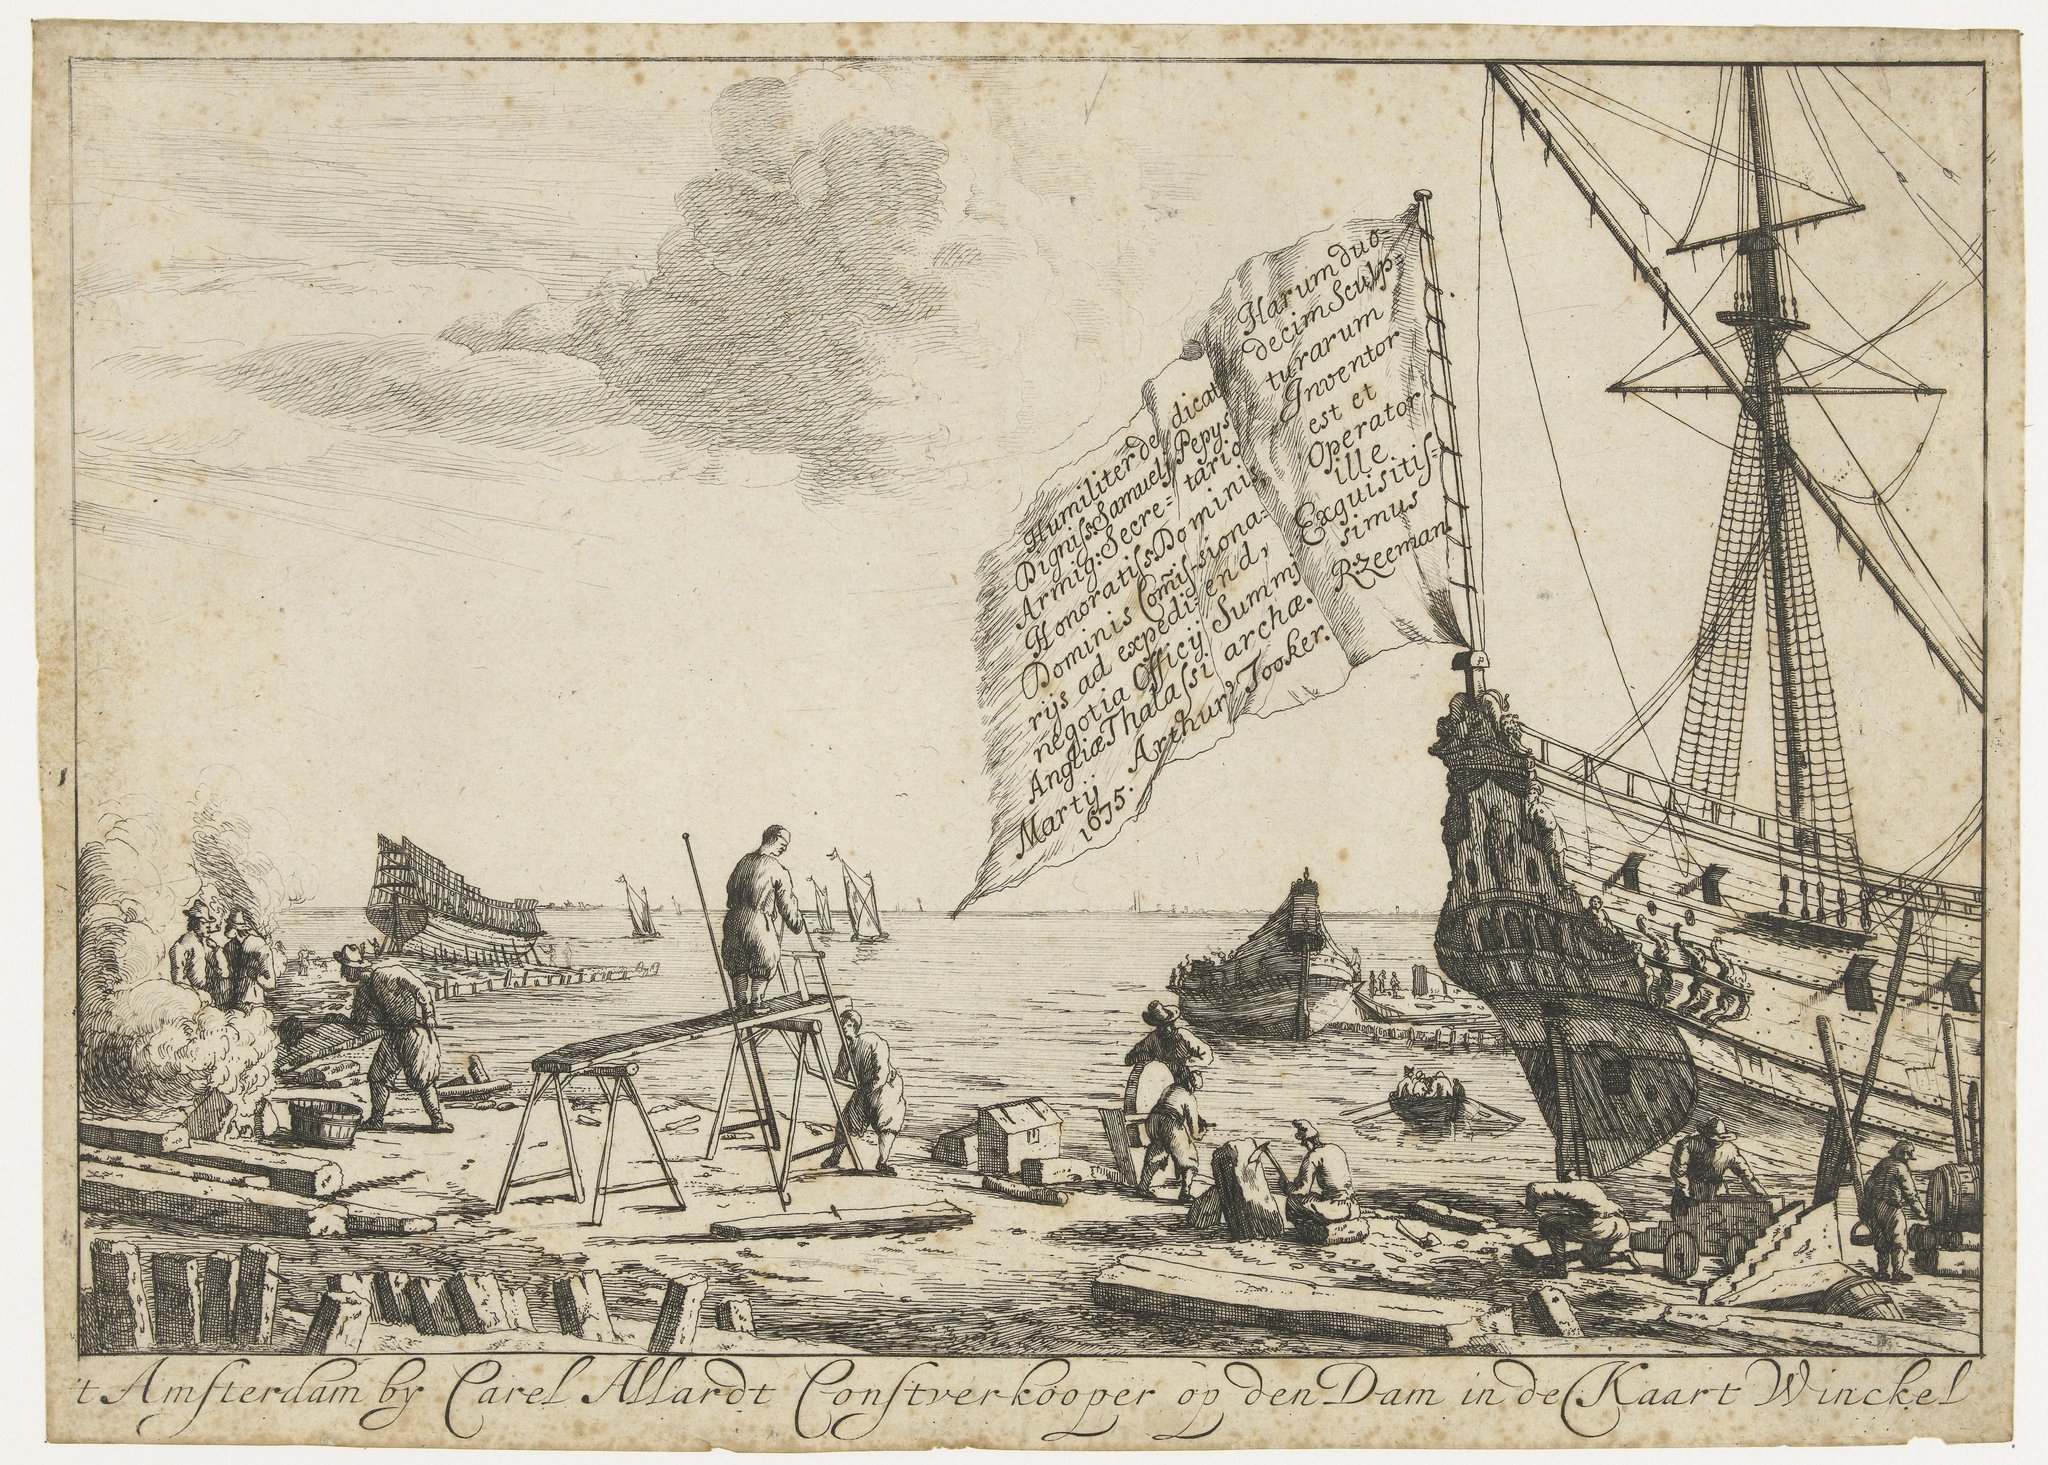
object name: titelprent, frontispice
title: Scheepswerf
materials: paper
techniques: etching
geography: dam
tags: building a ship, ship under construction, shipyard-workers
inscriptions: collector's mark: Lugt 2228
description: Kopie van een titelblad van een serie prenten door Zeeman. Scheepswerf met mannen aan het werk op de kade en drie grote zeilschepen in aanbouw liggend in de werf. Grote vlag met tekst in het Latijn.